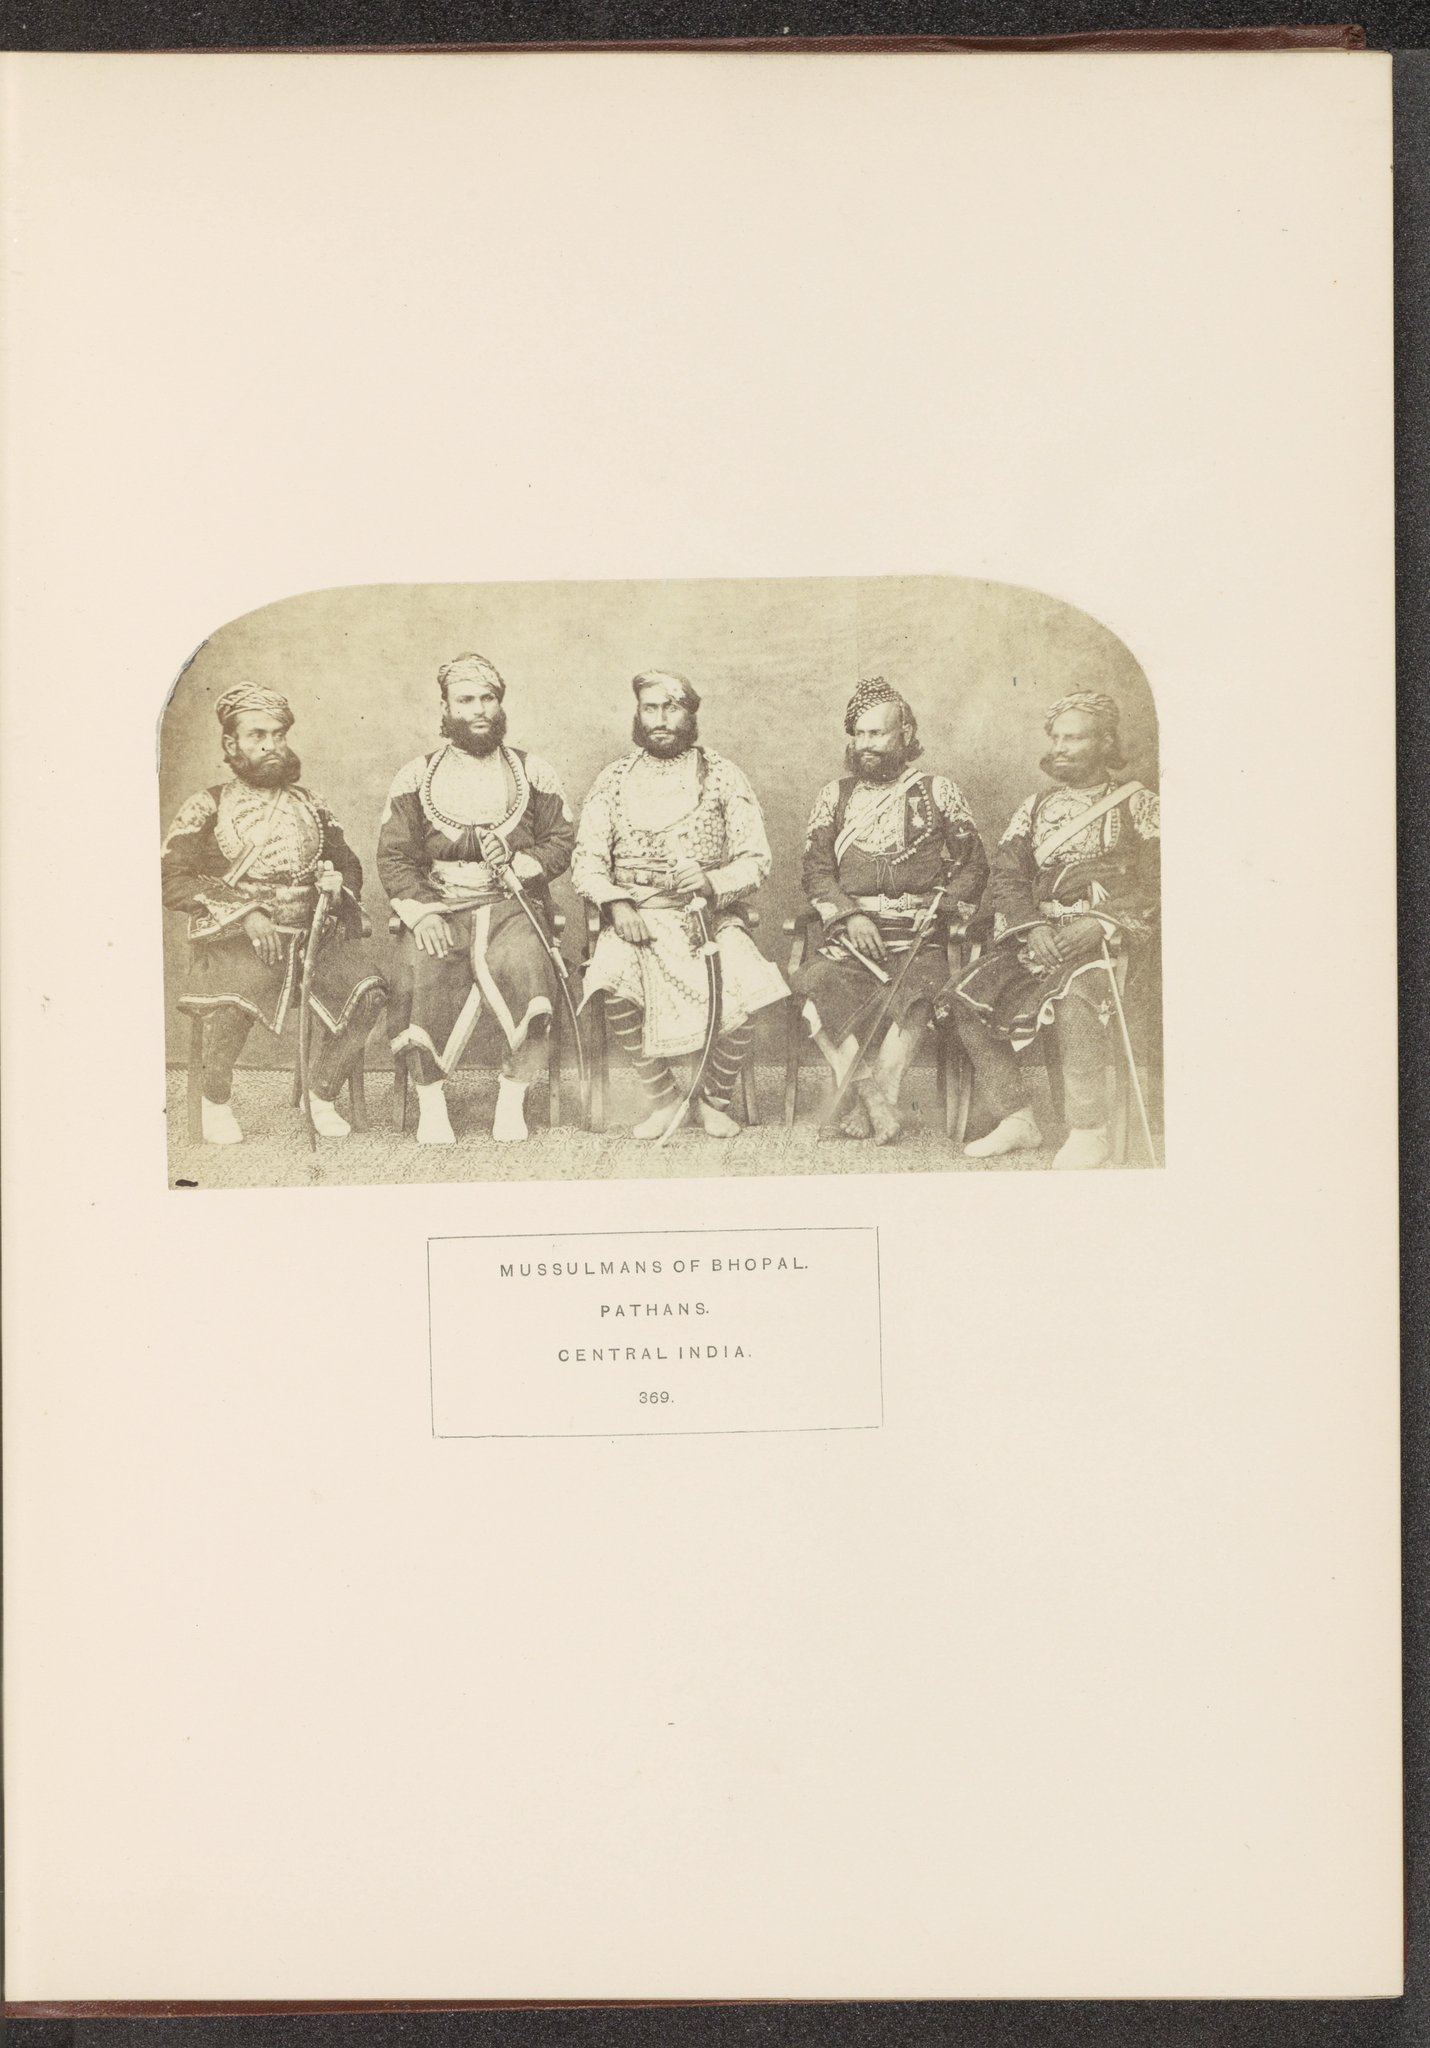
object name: page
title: Portrait of five officers in the service of Begum Sultan Shah Jahan of Bhopal, Madhya Pradesh, India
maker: james john waterhouse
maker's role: fotograaf, luitenant, officier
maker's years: 1842-1928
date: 1862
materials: photographic support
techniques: albumen print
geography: bhopal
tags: officer, human races; peoples; nationalities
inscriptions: number: ‘369.’, inscription: ‘MUSSULMANS OF BHOPAL./ PATHANS./ CENTRAL INDIA.’